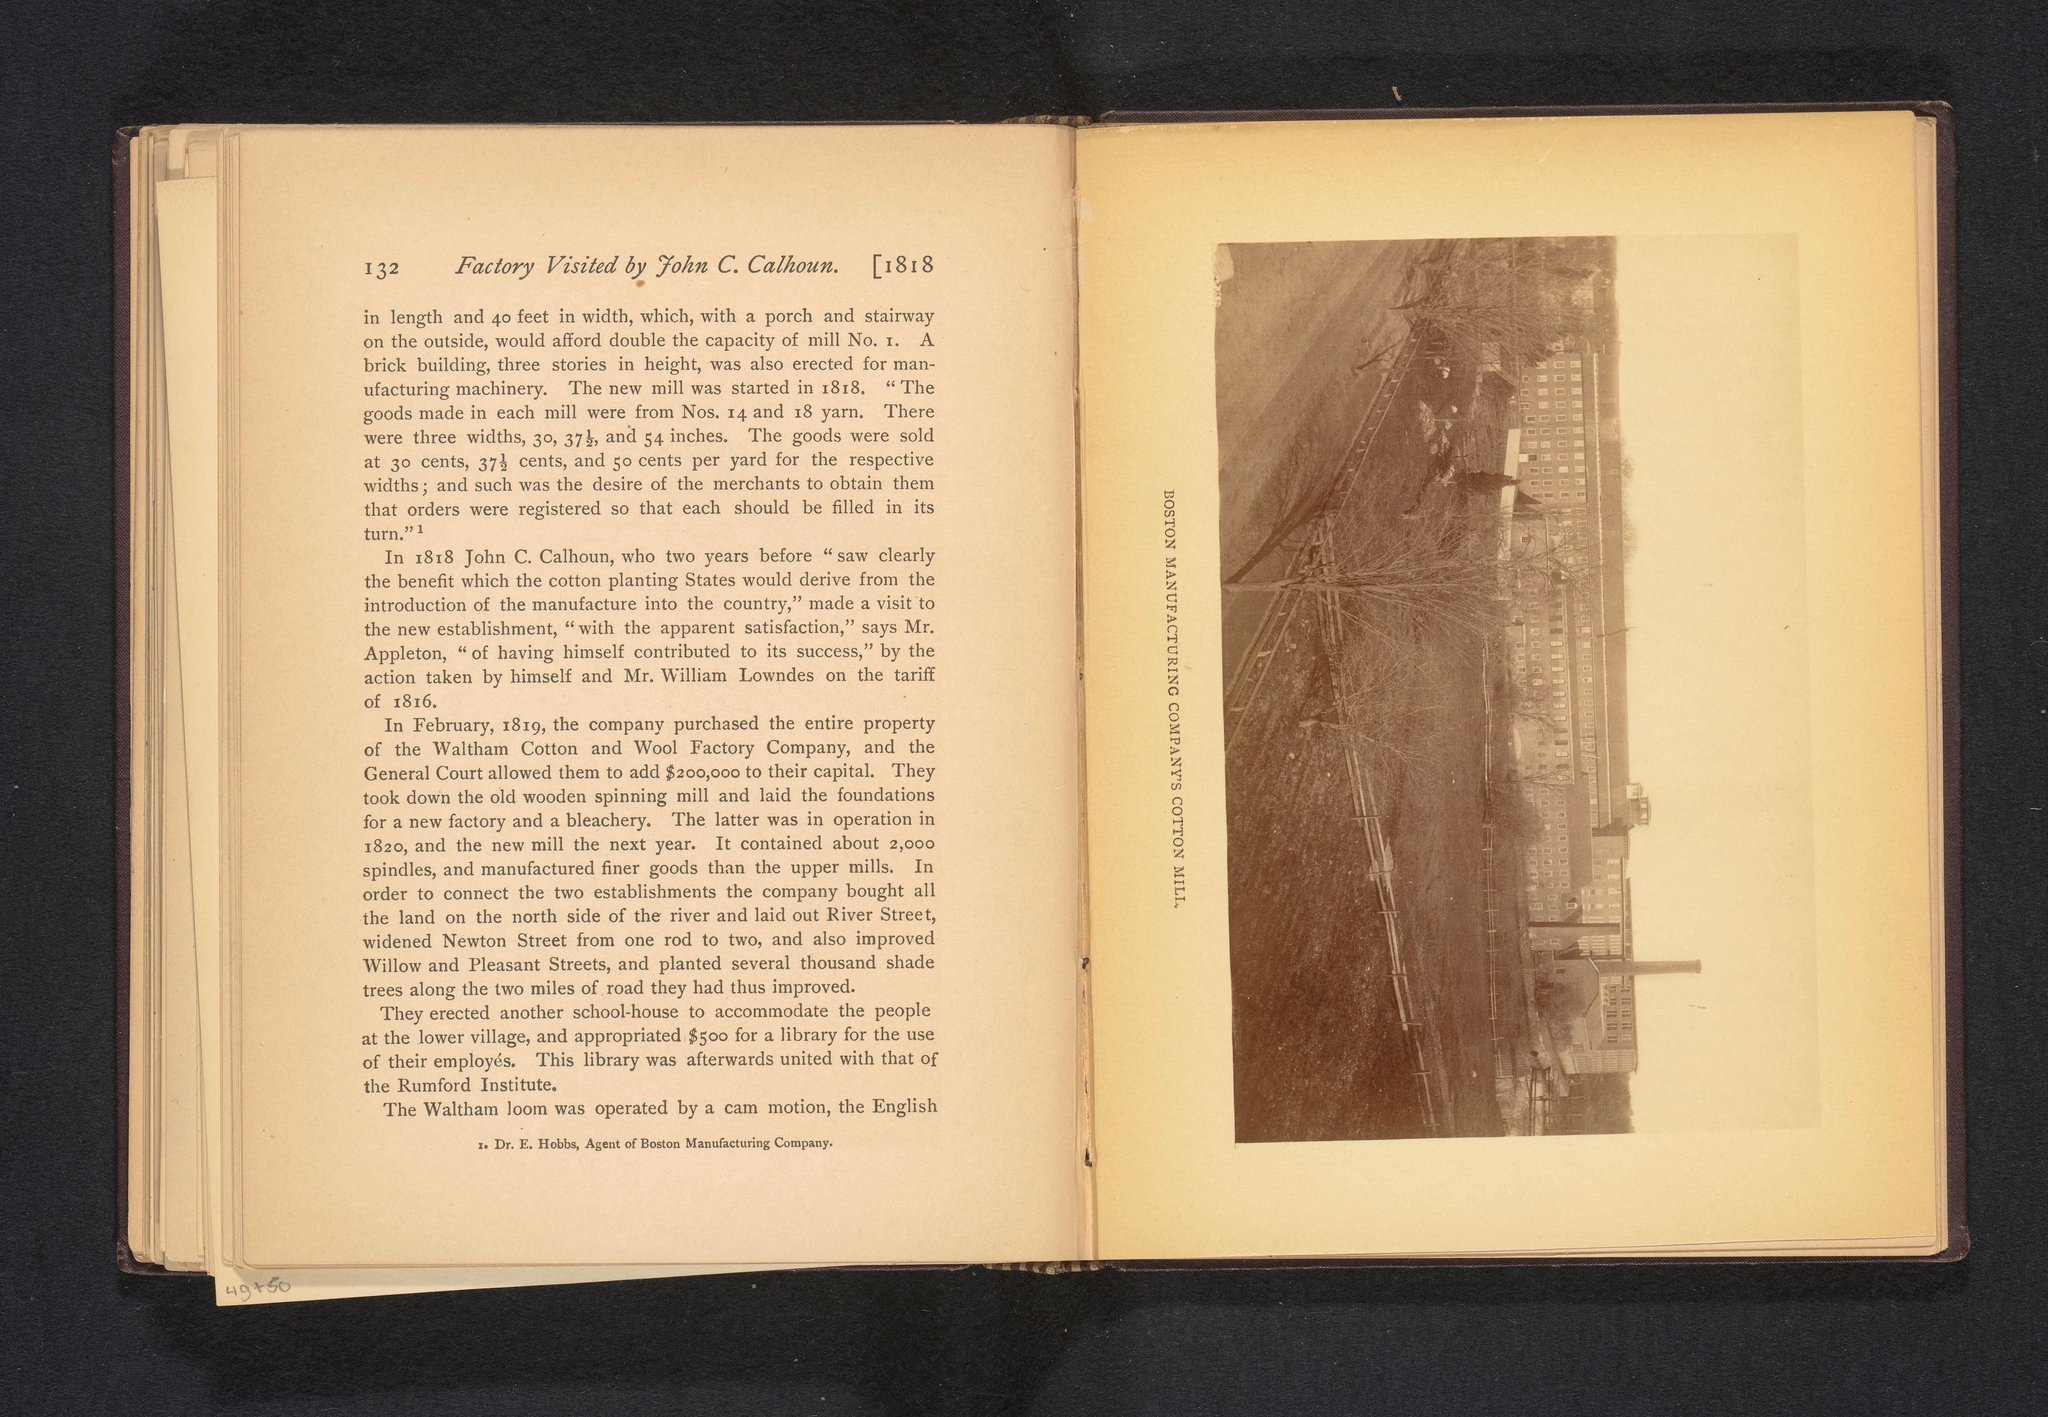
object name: photograph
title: Boston Manufacturing Company's Cotton Mill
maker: thomas r. lewis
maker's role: publisher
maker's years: 1845-1901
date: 1874-1879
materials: photographic support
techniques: albumen print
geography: waltham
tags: factory-building, cotton (material ~ textile industry)